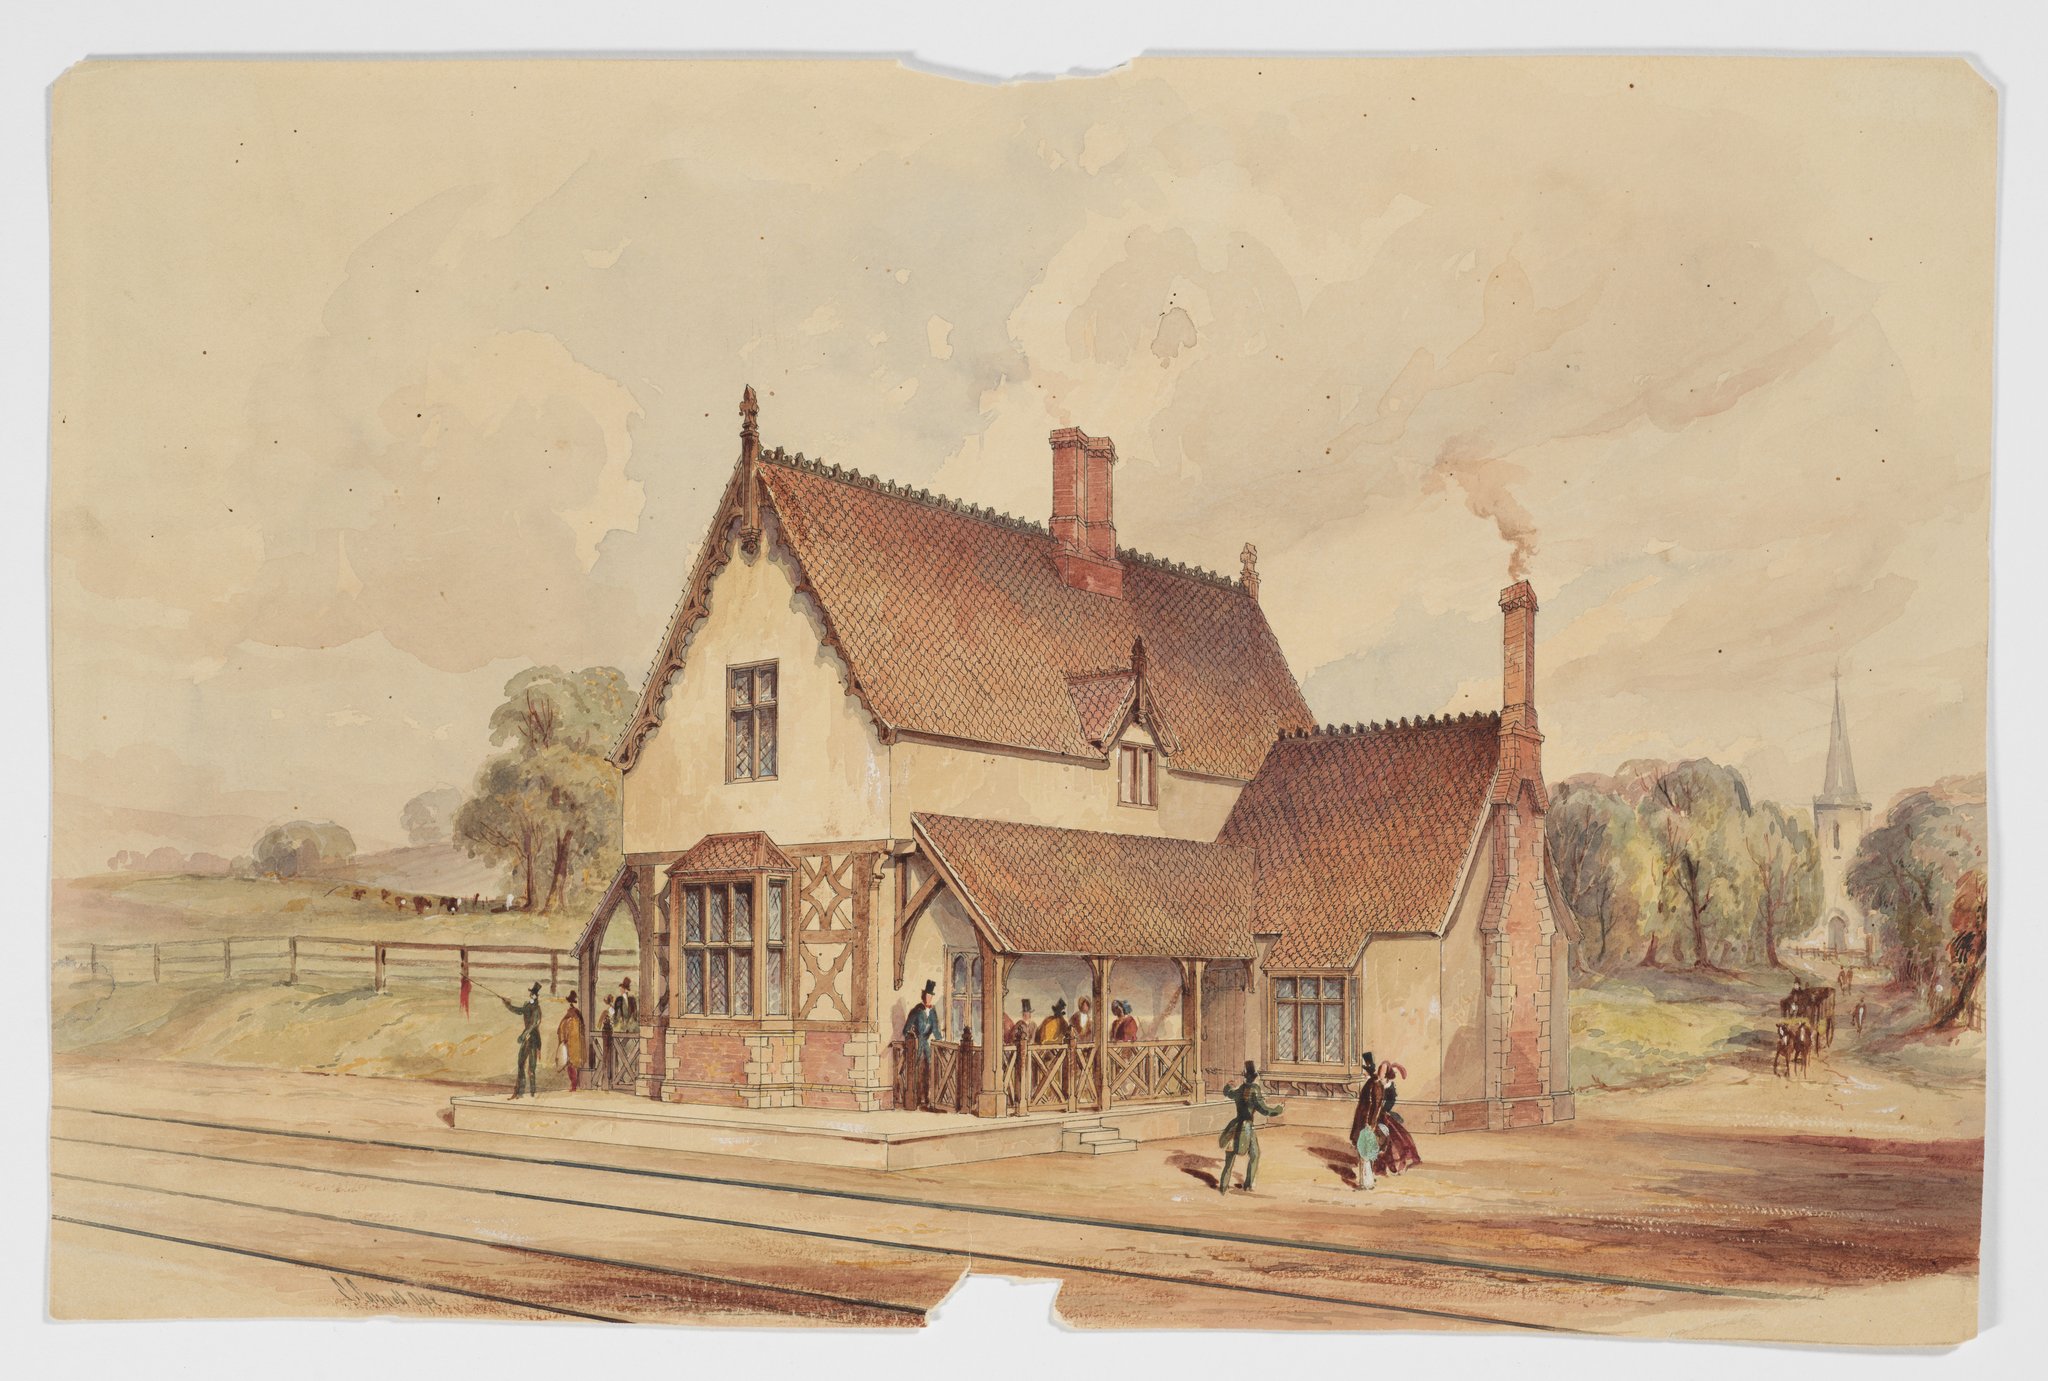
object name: ornament architecture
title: Victorian Rural Train Station and Railroad Crossing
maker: john connell ogle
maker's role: artist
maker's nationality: british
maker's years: 1813-1877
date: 1844-1877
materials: ink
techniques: pen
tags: train stations,railways